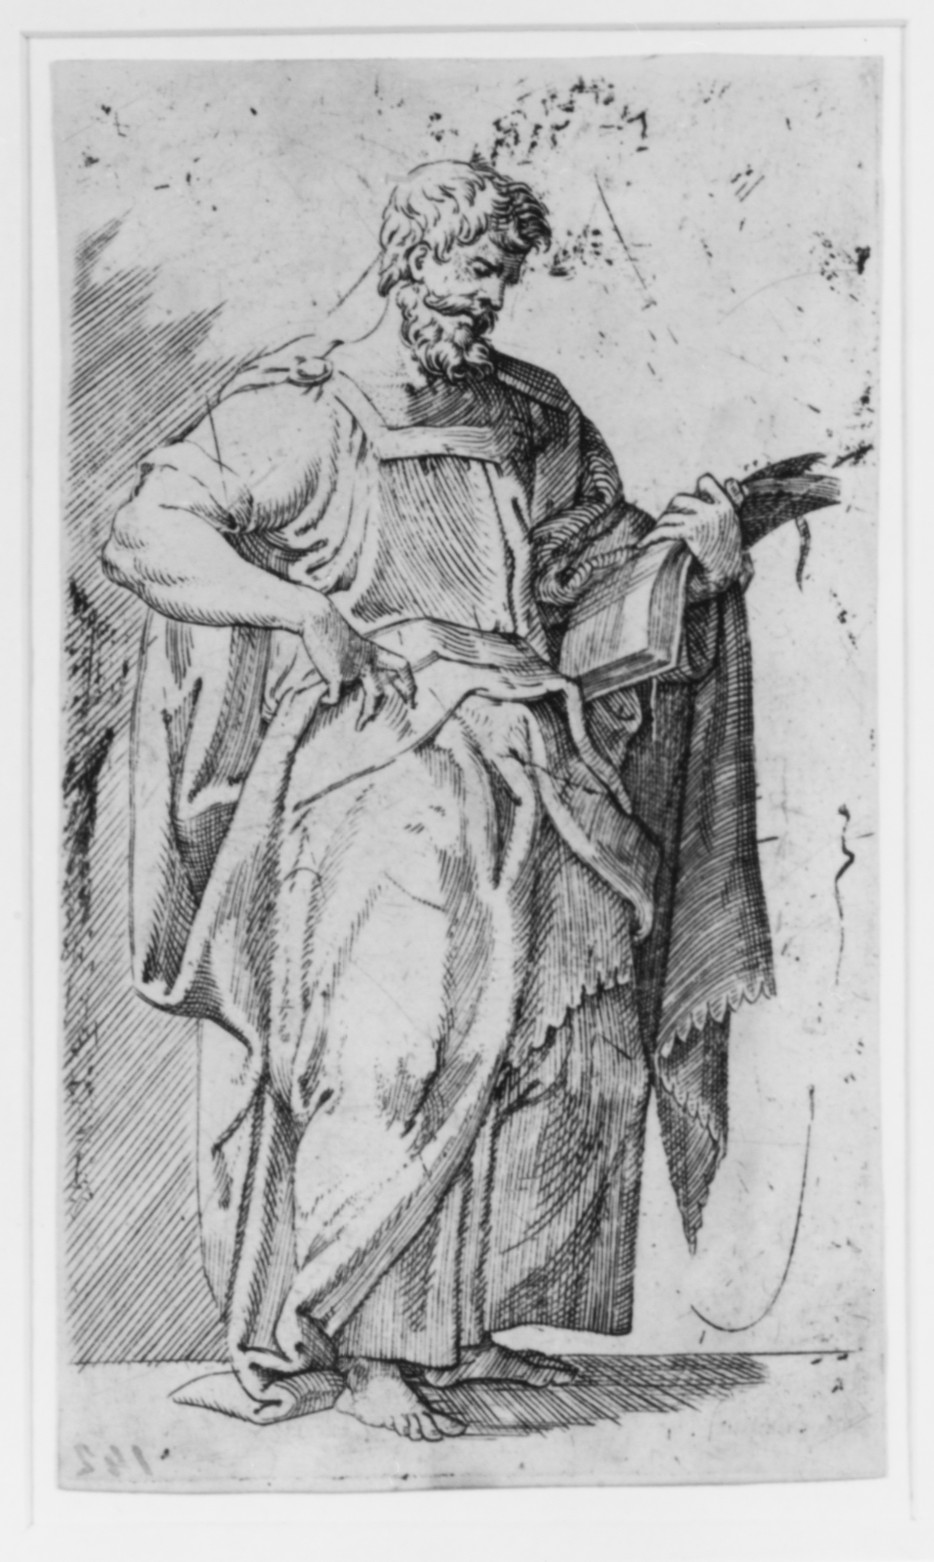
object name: print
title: An Apostle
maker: angiolo falconetto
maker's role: artist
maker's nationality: italian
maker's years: 1555-1567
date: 1555-1567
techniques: etching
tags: books,reading,apostles